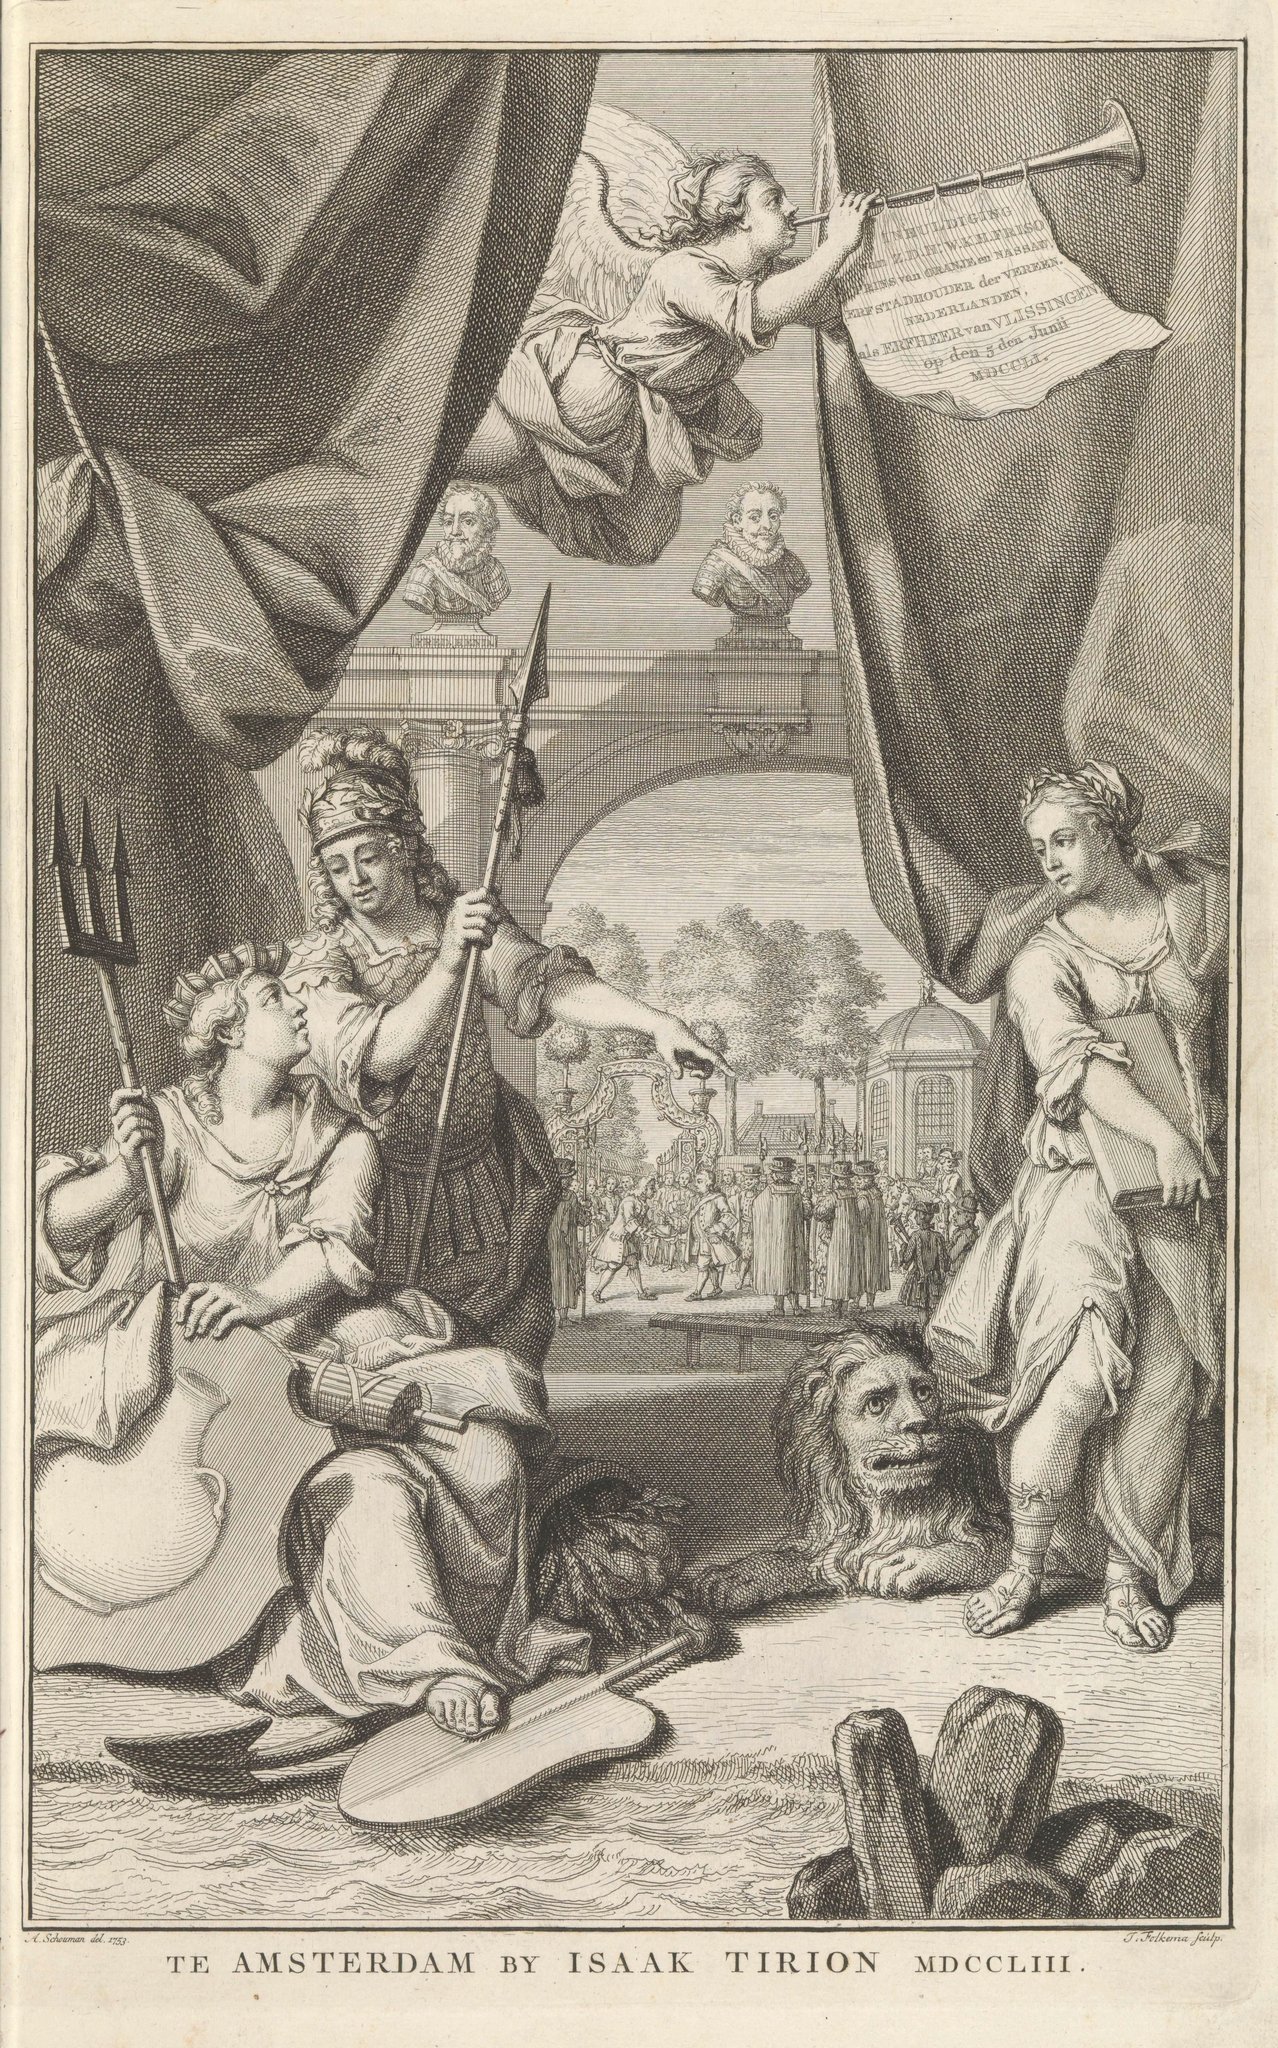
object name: titelblad, titelpagina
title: Allegorische titelplaat met het aanbieden van de sleutels, 1751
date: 1753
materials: paper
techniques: engraving, etching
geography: amsterdam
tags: the hague, willem iv (prins van oranje-nassau), surrender of keys, flushing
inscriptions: date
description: Allegorische titelplaat met het aanbieden van de sleutels van de stad aan de stadhouder. Op de voorgrond de stadsmaagd van Vlissingen met Mars, rechts de Geschiedenis, in de lucht de Faam. Illustratie in het boek over de inhuldiging van Willem IV als erfheer van Vlissingen op 5 juni 1751.